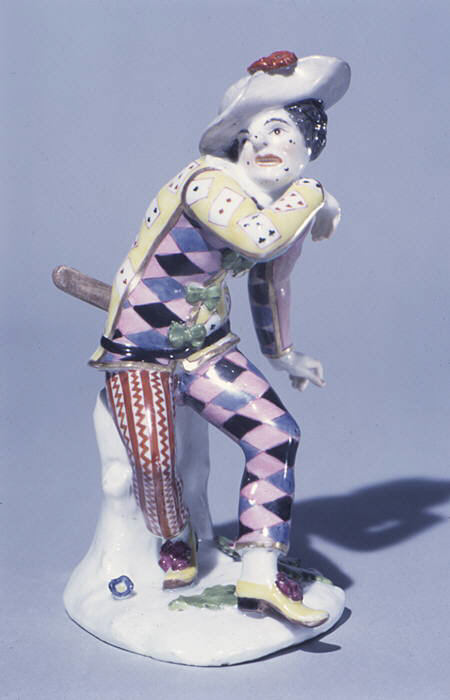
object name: figure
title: Frightened Harlequin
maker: meissen manufactory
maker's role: manufactory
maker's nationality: german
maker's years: 1710-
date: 1740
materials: hard paste porcelain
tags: men